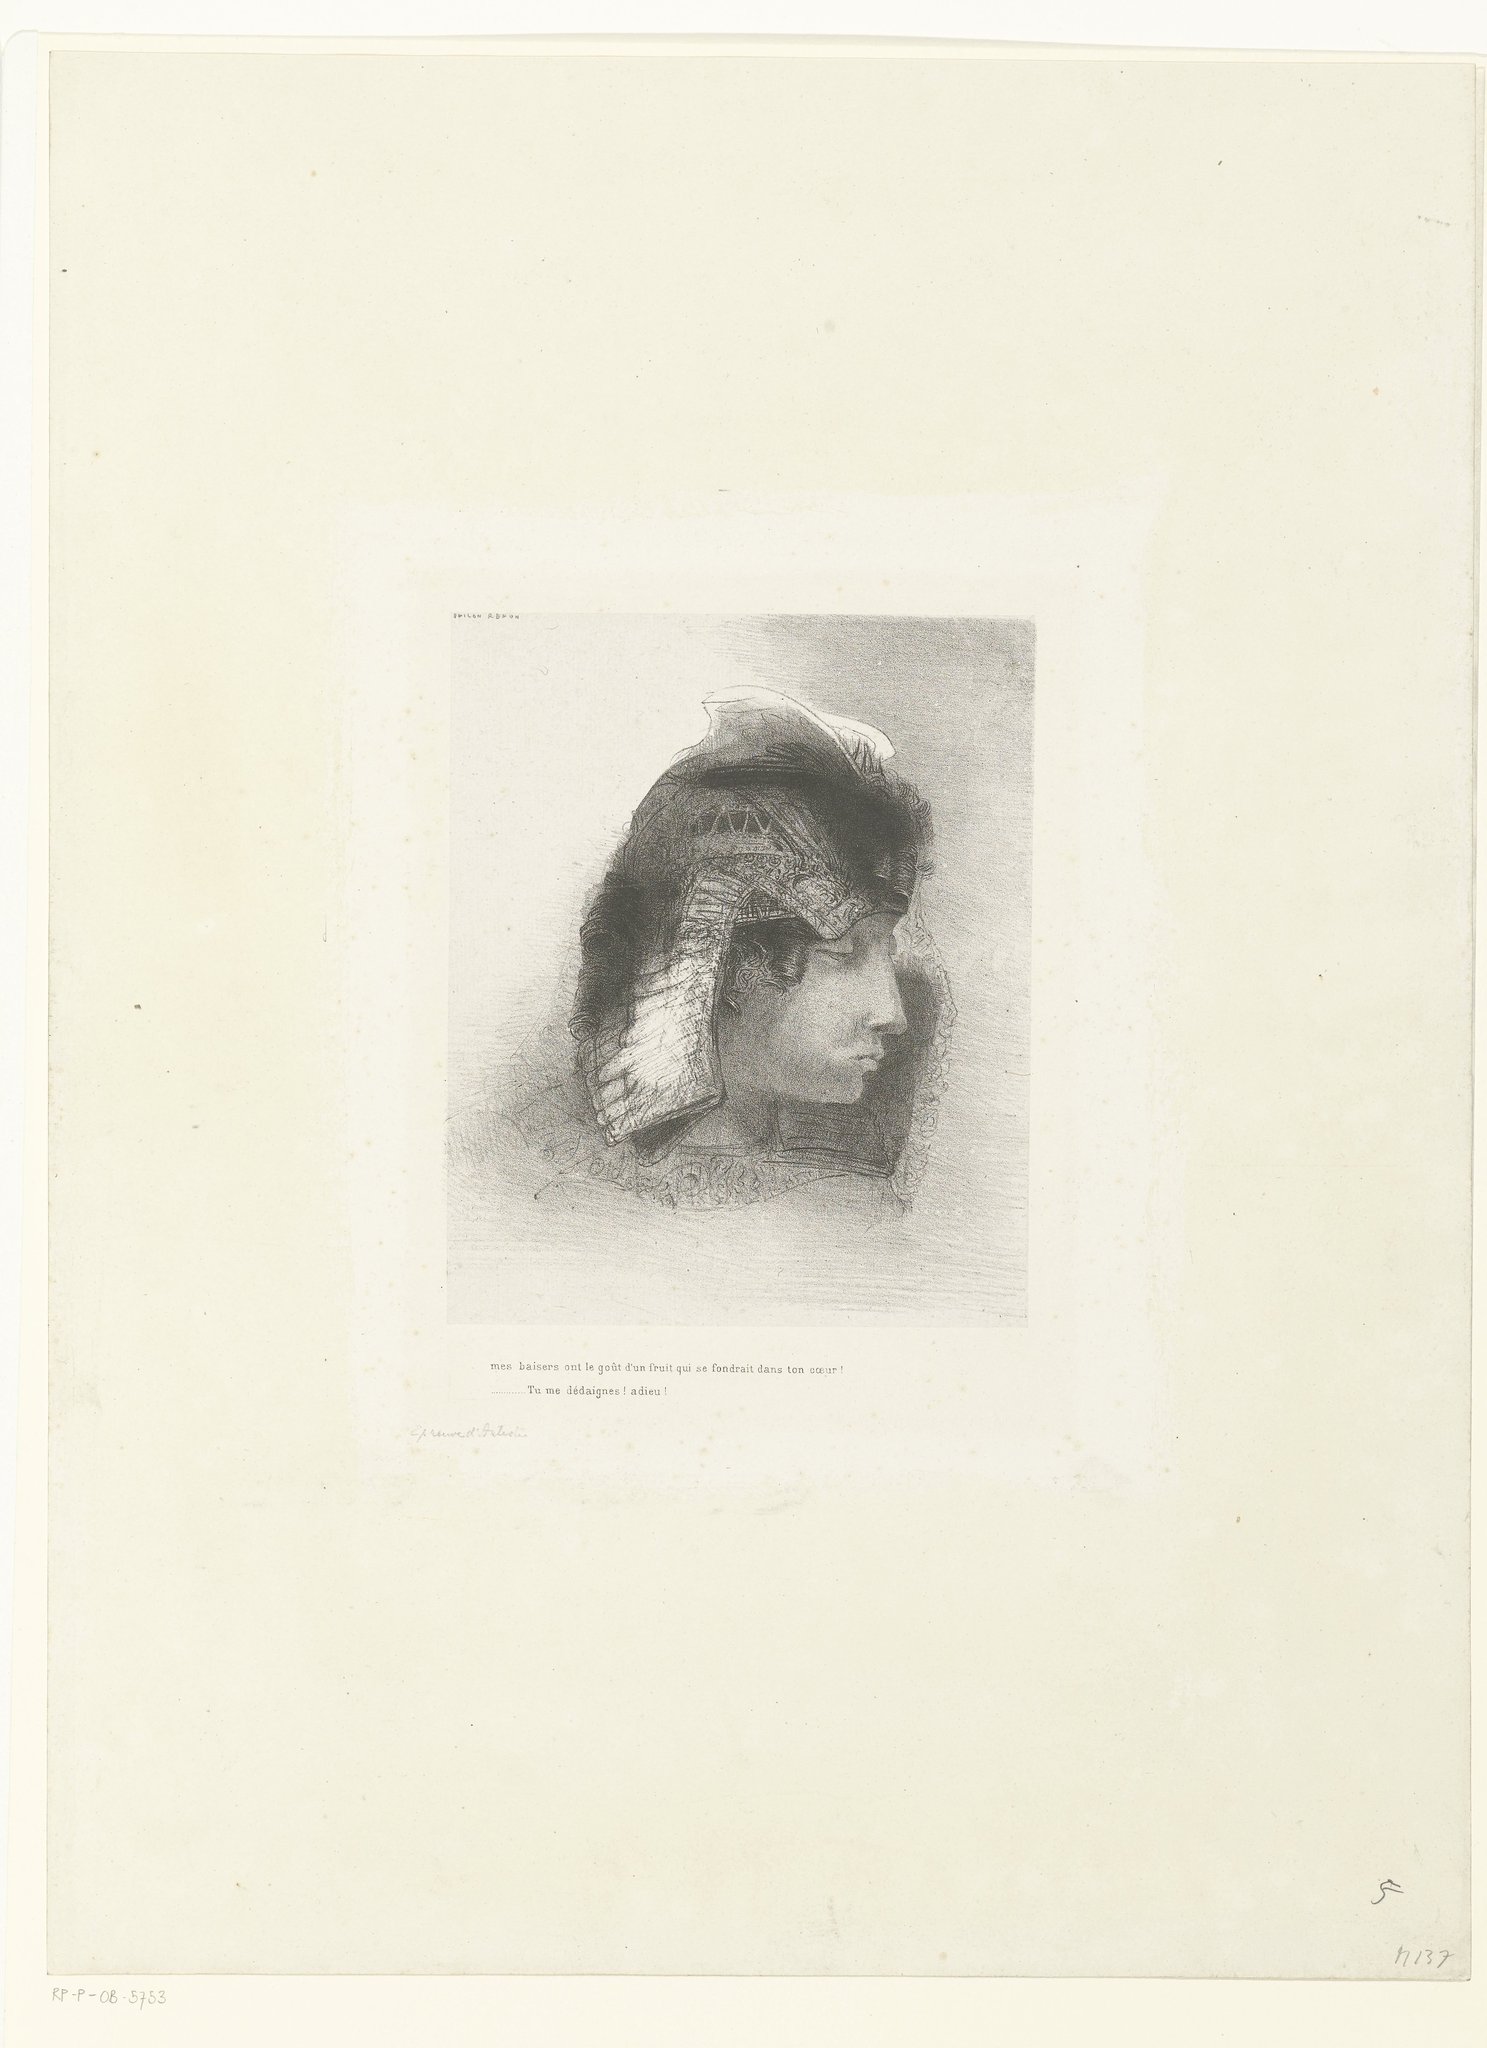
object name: print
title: Mijn kussen hebben de smaak van een vrucht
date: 1896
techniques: printmaking, lithograph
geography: paris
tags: temptations of st. antony abbot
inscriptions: collector's mark: Lugt 2228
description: Kop van een man met een hoofddeksel. Onder de afbeelding de tekst: Mijn kussen hebben de smaak van een vrucht die in je hart zou smelten..... Je bespot me! adieu!. Vierde prent van vierentwintig, uit de derde serie illustraties voor Gustave Flauberts De verzoeking van de heilige Antonius.